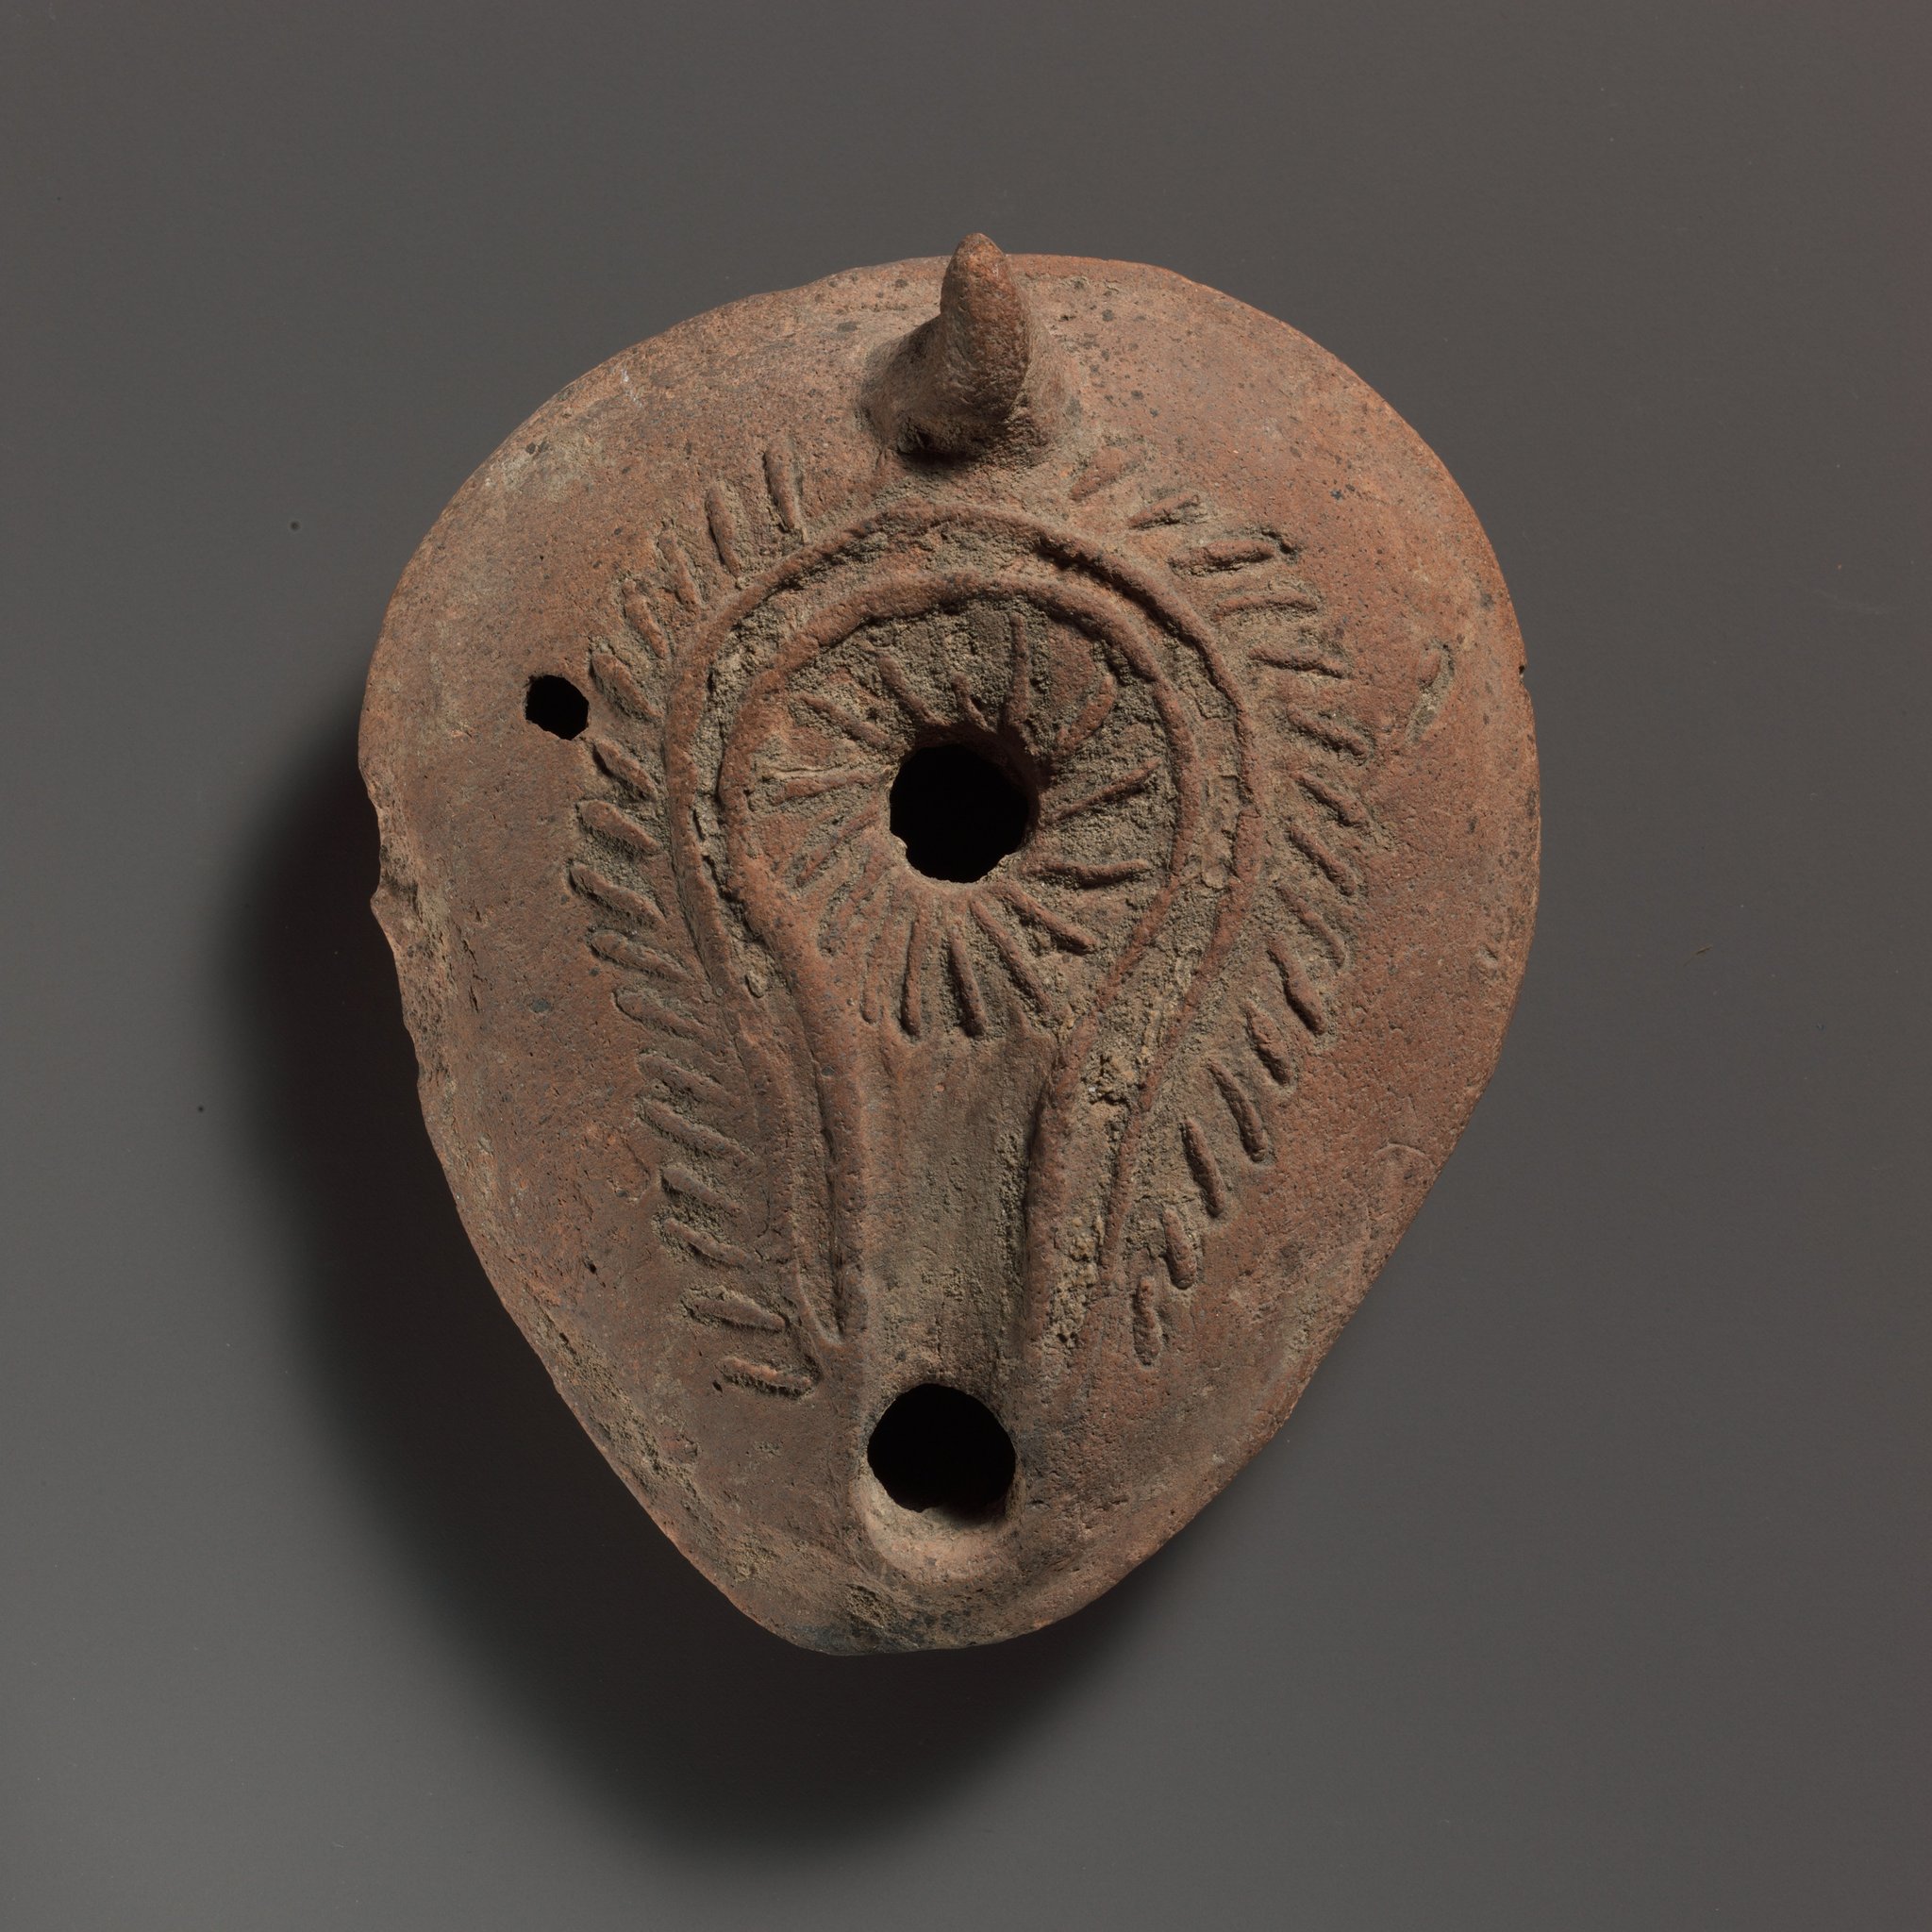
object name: lamp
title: Terracotta oil lamp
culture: roman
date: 601-700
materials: terracotta